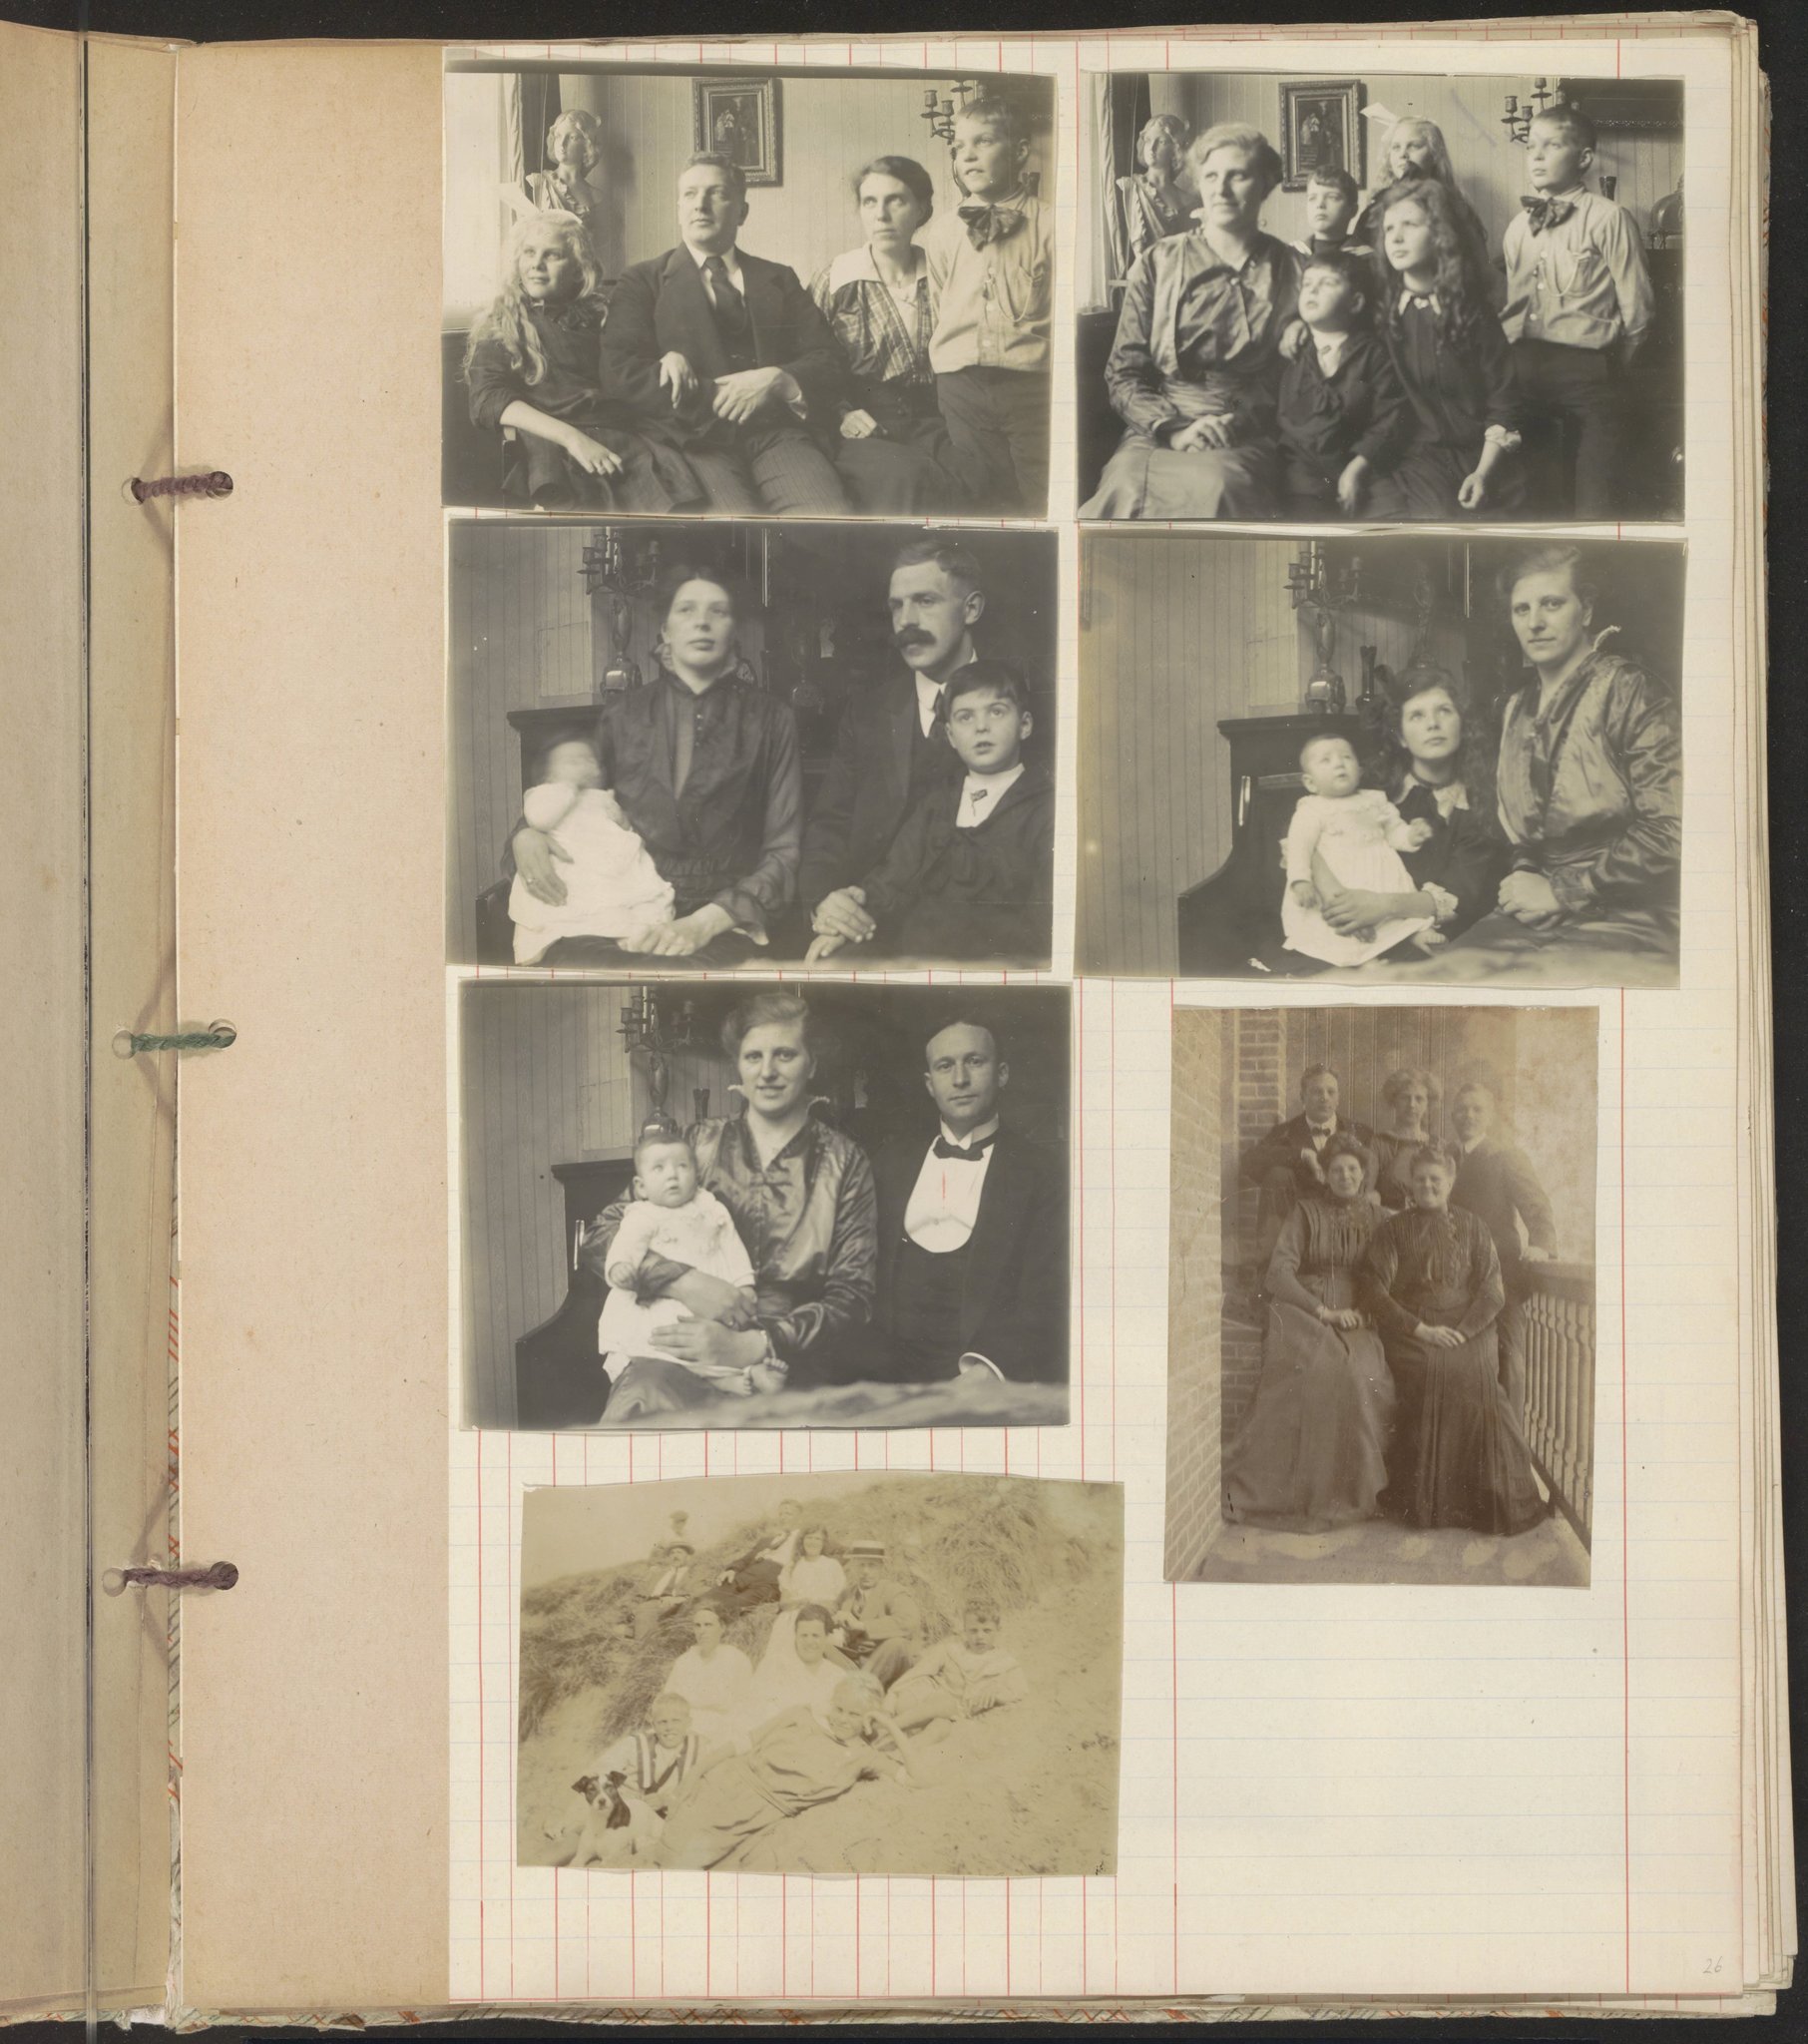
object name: album leaf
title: Portretten van onbekende personen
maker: Anonymous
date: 1910-1930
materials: paper, photographic support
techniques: gelatin silver print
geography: netherlands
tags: adult woman, parents with their children, adult man, child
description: Albumblad met portretten van ouders met kinderen, gemaakt in huiselijke kring. Onderdeel van Fotoalbum van de familie Petri.